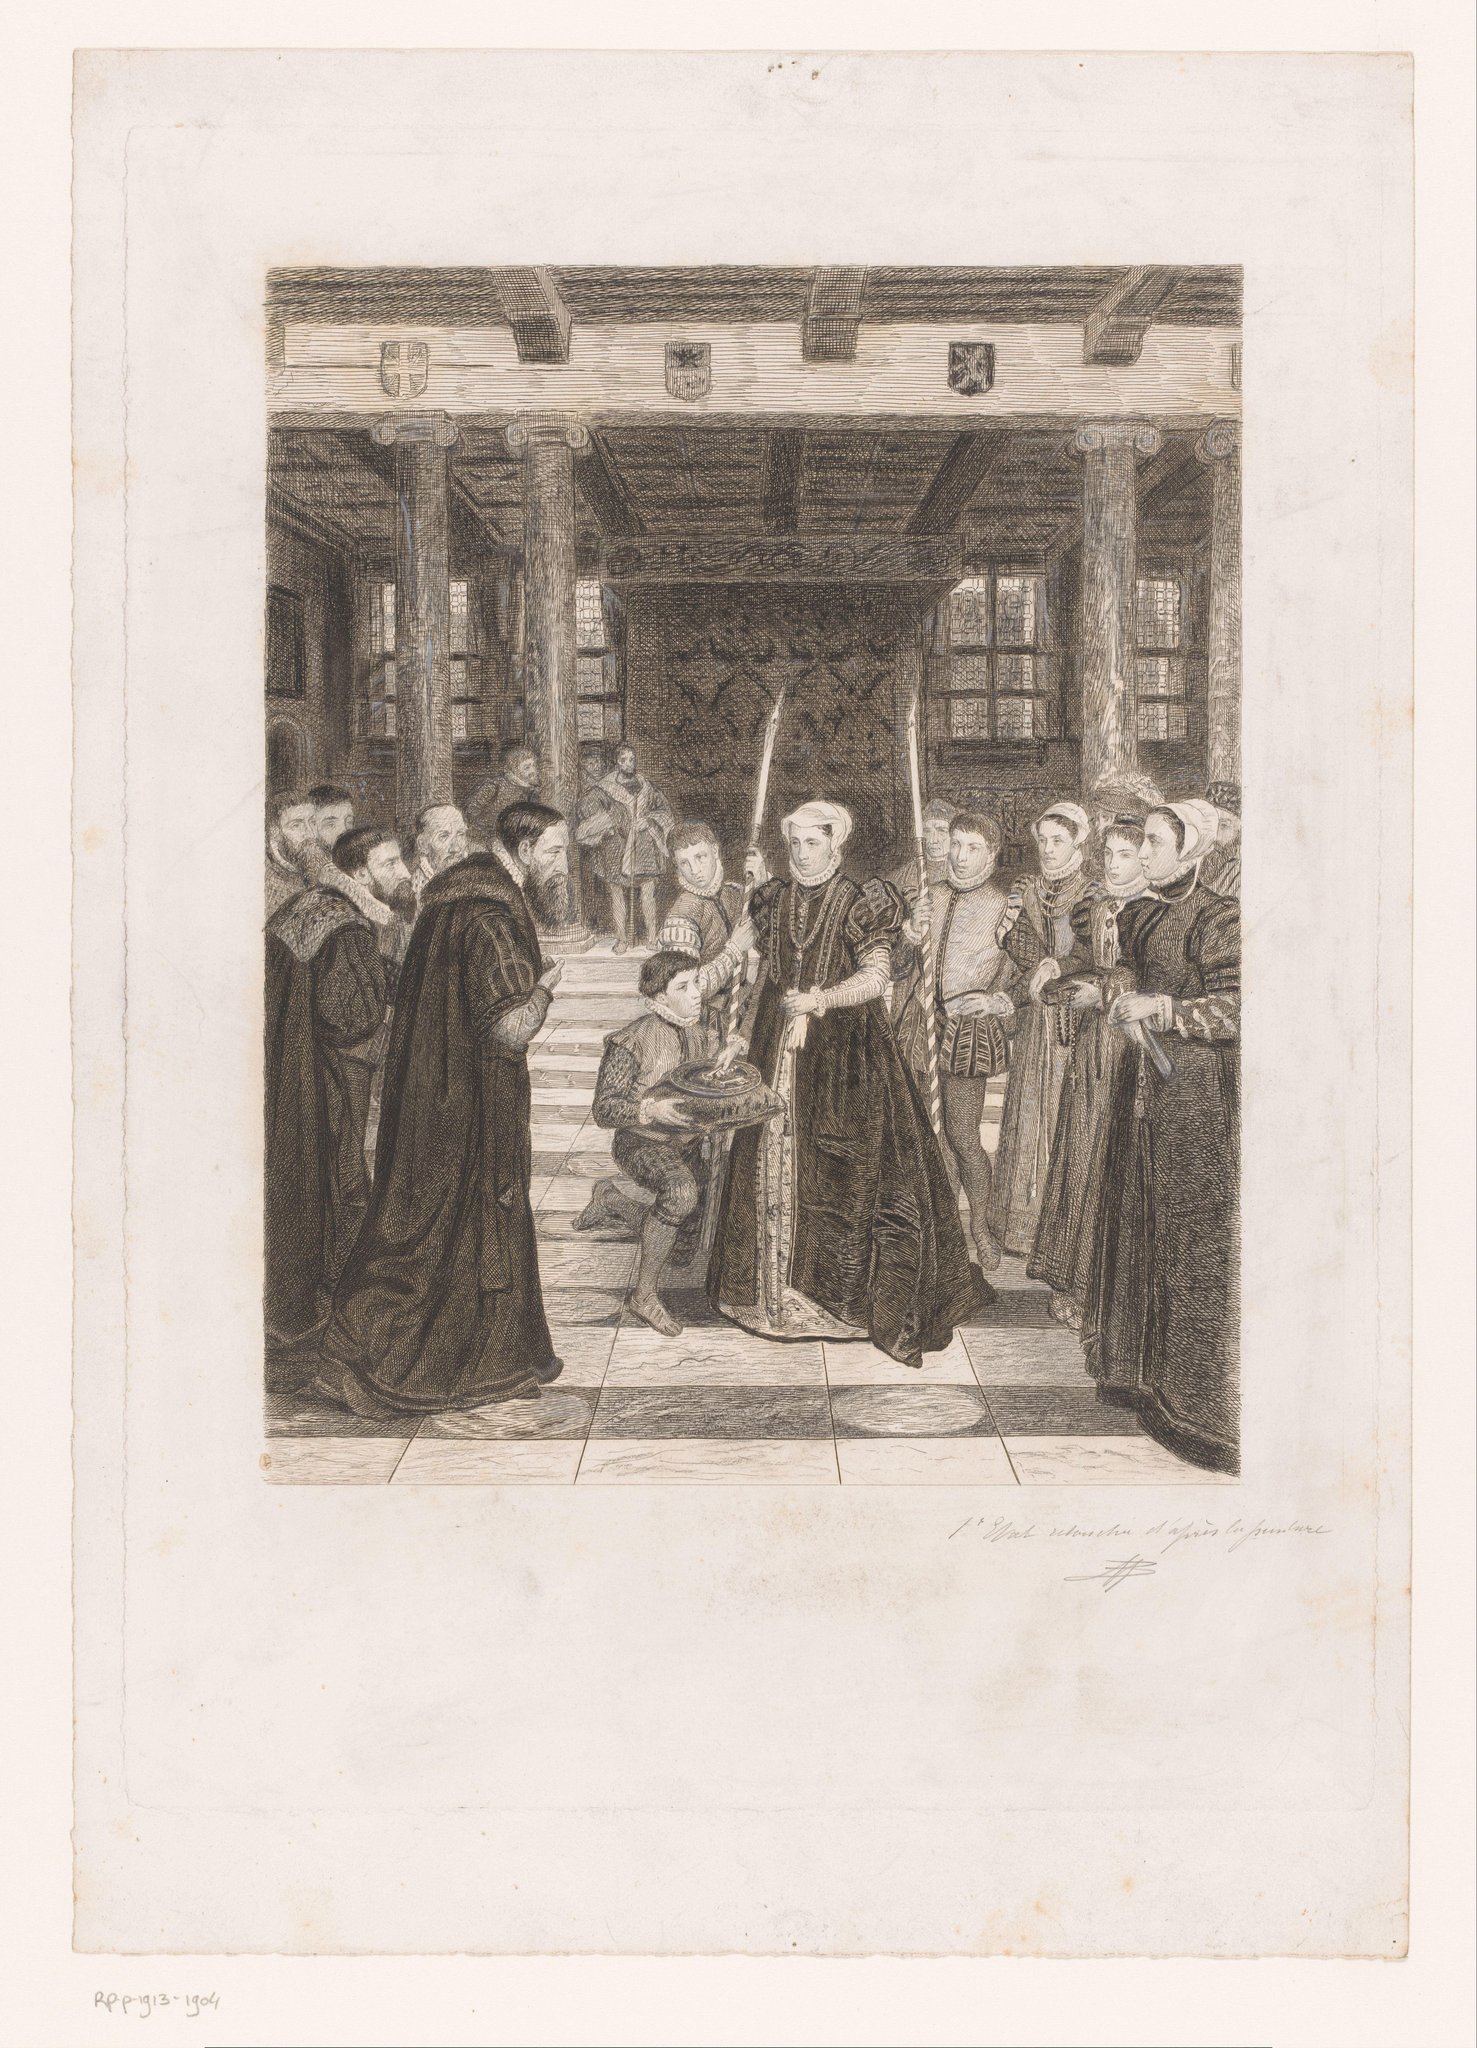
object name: print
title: Margaretha van Parma overhandigt de stadssleutels aan de Antwerpse magistraat in het stadhuis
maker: jean baptiste pierre michiels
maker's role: print maker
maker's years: 1821-1890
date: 1863-1890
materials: paper, pencil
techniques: etching, intaglio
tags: key, townhall, interior ~ representation of a building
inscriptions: collector's mark: Lugt 2228, inscription: ‘1e Etat retouchée d'apres la peinture’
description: De prent is gemaakt naar de muurschilderingen van Henri Leys in het Stadhuis van Antwerpen. Een latere staat van de plaat is gebruikt in: Leys, Henri. De Zaal Leys op het Stadhuis van Antwerpen: zeven kopersneden naar de muurschilderingen van Baron H. Leys. Antwerpen: Museum Plantin-Moretus, 1902.